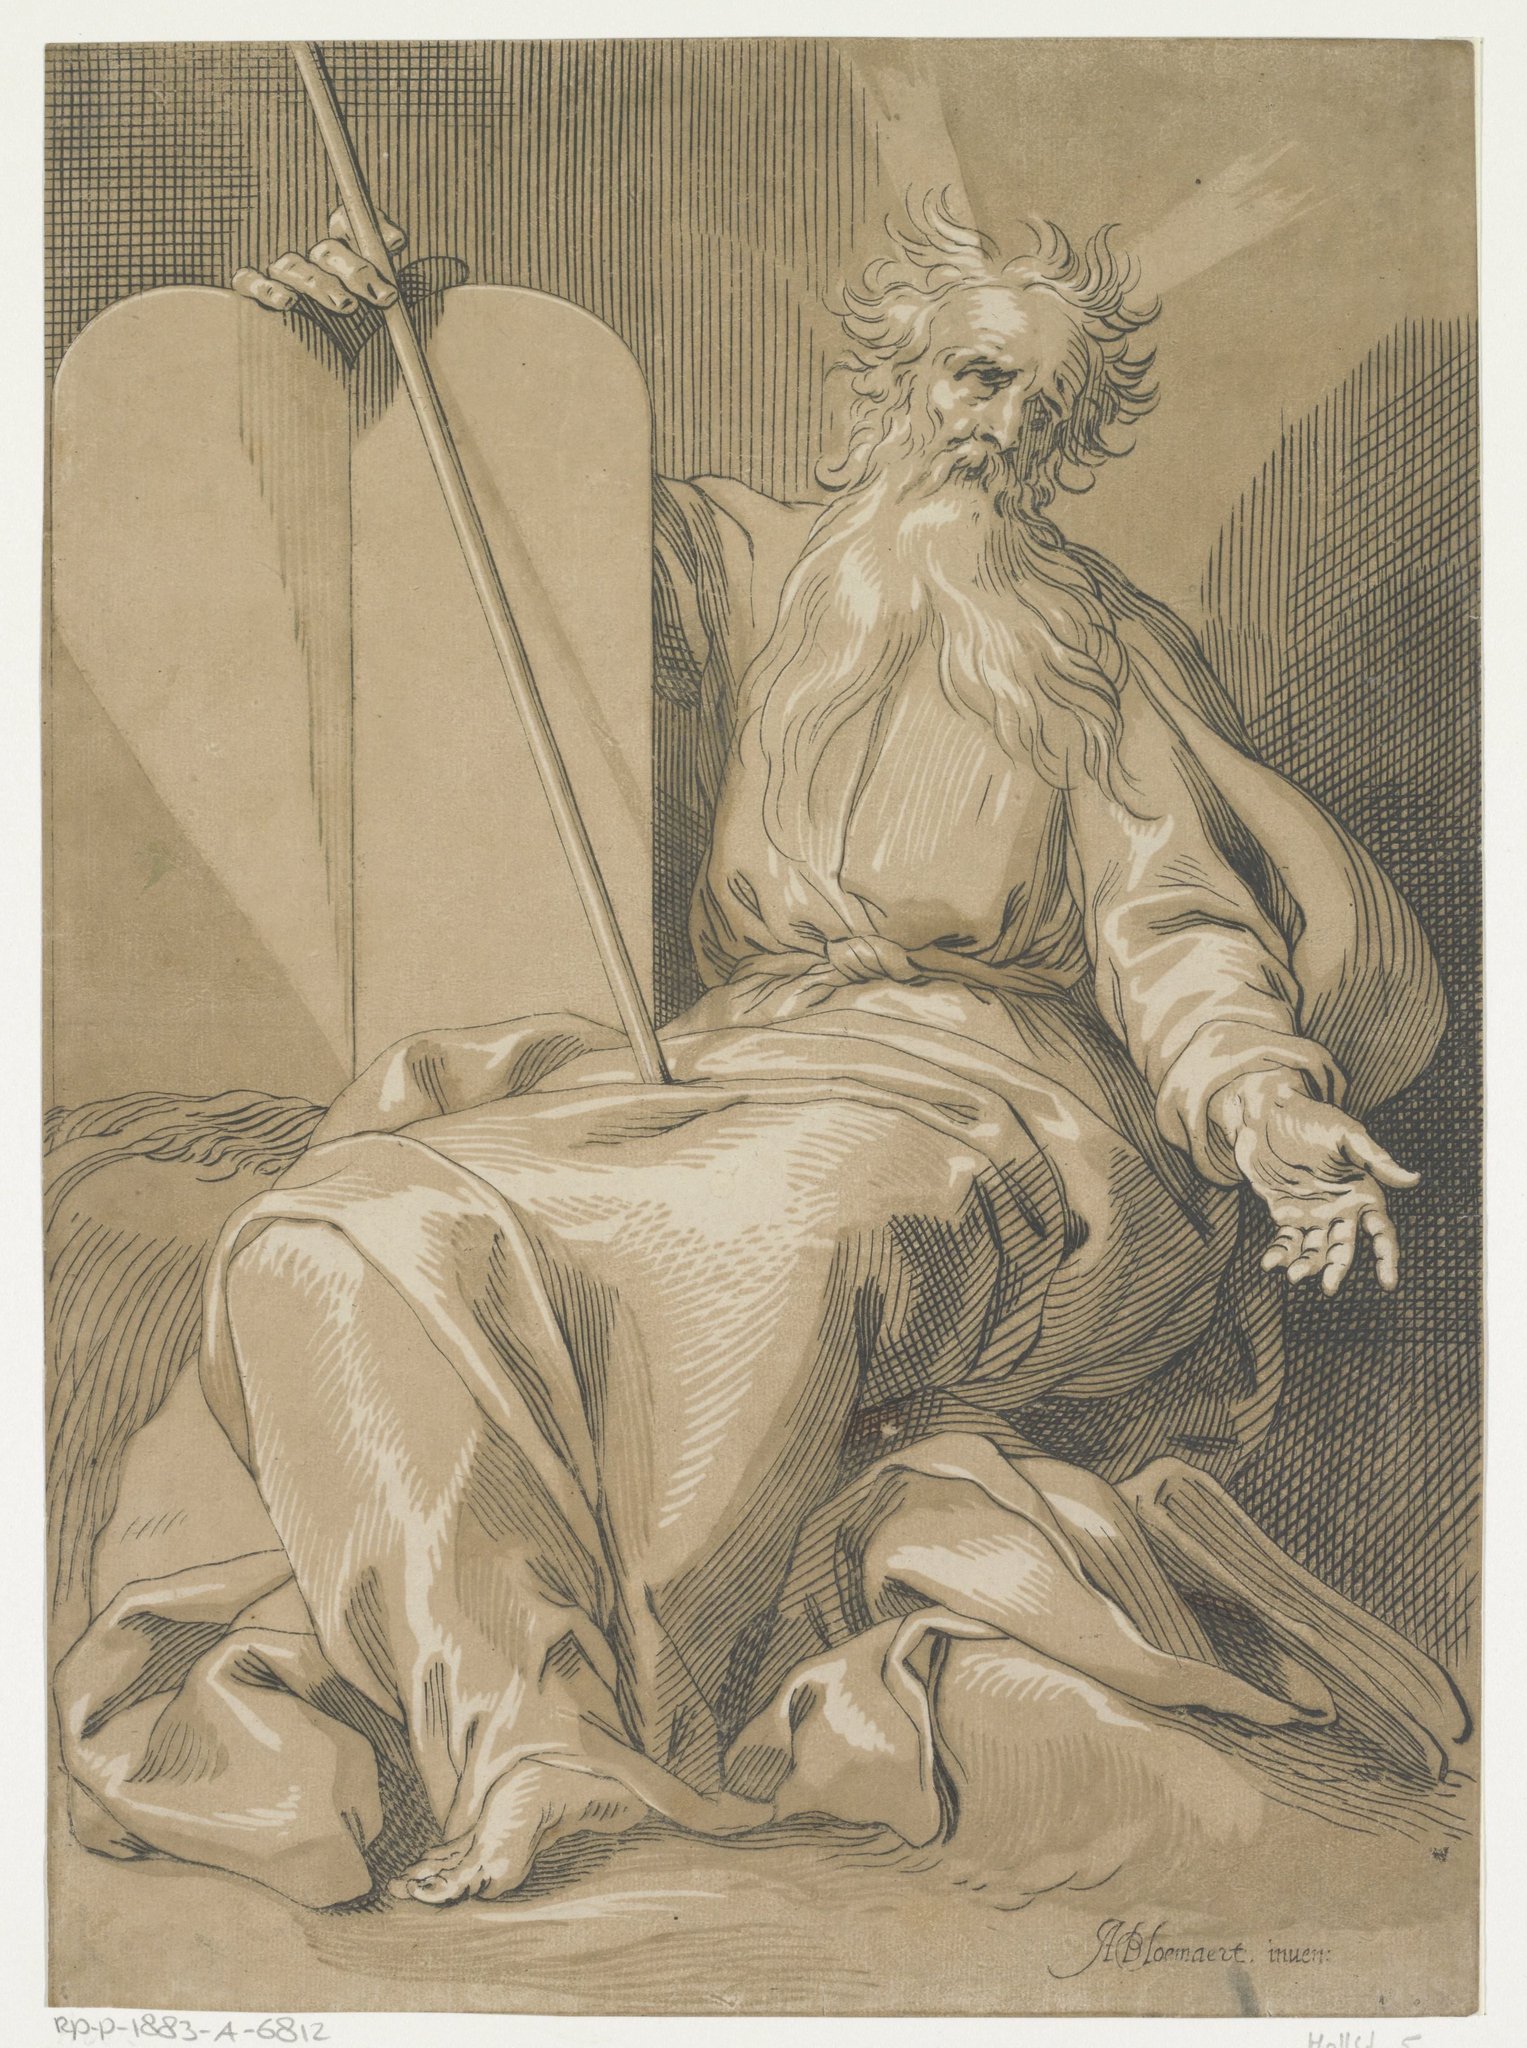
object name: print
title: Mozes met de tafelen der wet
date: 1610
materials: paper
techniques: woodcut, etching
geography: netherlands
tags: moses (not in biblical context); possible attributes: rays of light or horns on his head, rod, tables of the law, the ten commandments represented together on stone tablets